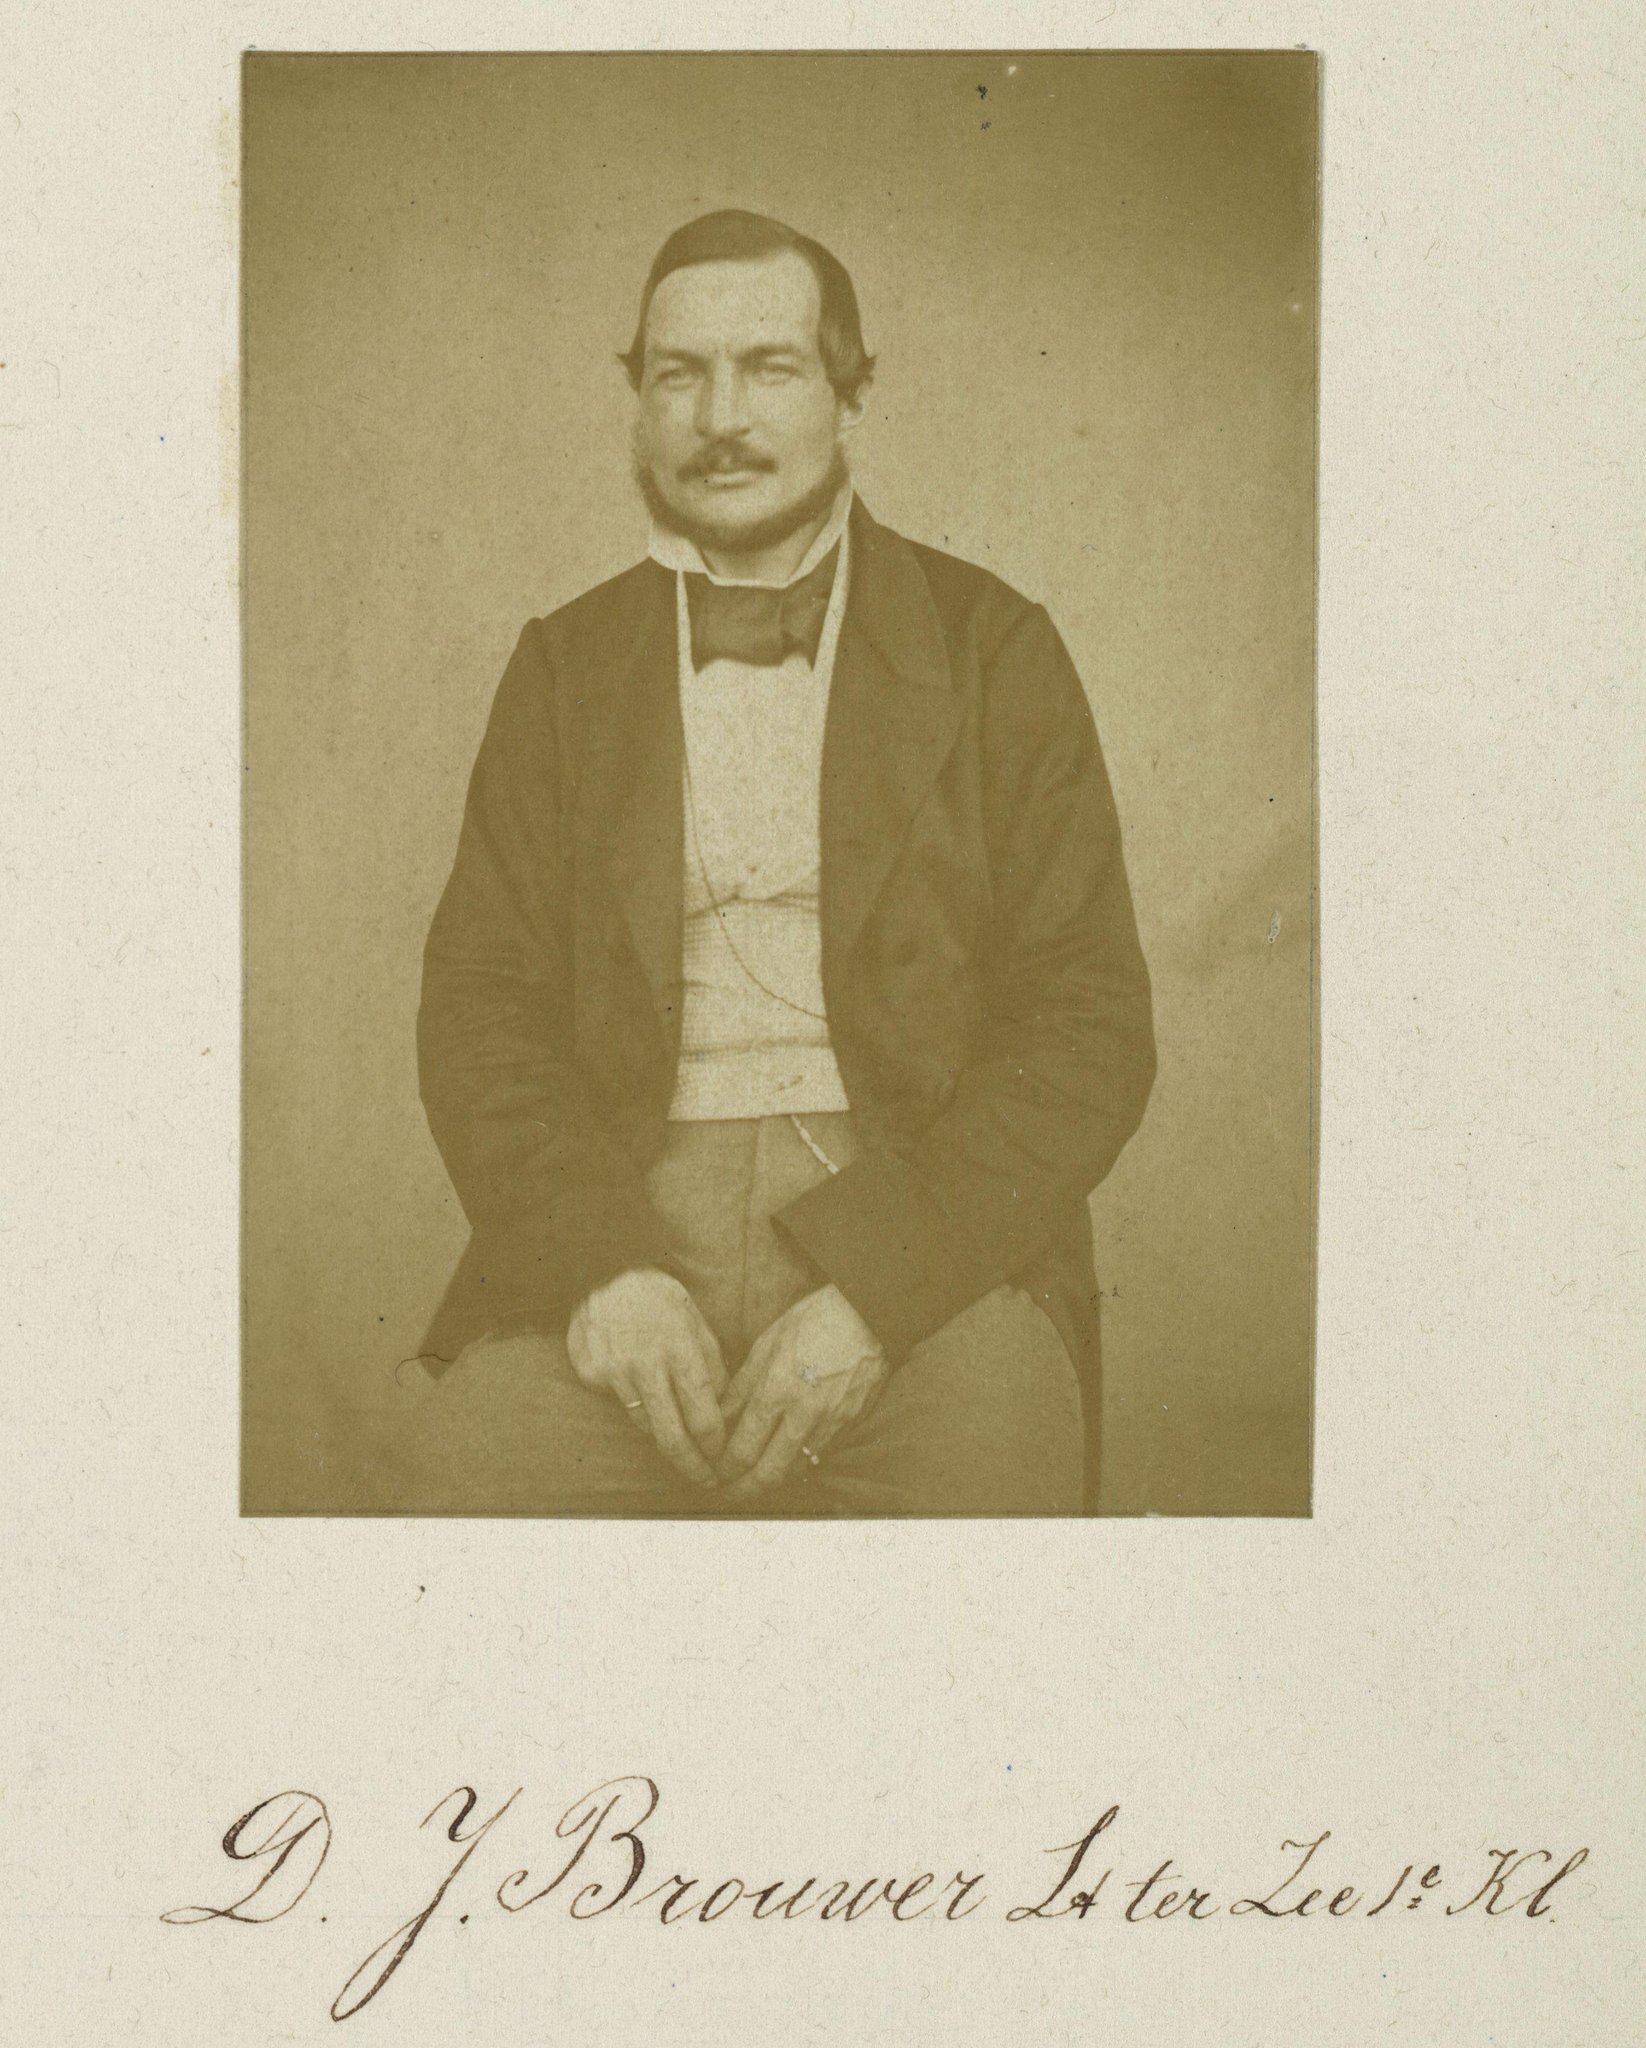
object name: photograph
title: D.J. Brouwer Lt ter Zee 1e Kl.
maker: pieter jan kaiser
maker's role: fotograaf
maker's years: 1838-1916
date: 1855-1880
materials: cardboard, paper, photographic support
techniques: albumen print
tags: historical persons, science and technology (+ portrait of scholar, scientist)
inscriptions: inscription: ‘Tijdelijk belast met astronomische waarnemingen in de zwwvaart, bij de ... waart’, annotation: ‘D.J. Brouwer Lt ter Zee 1e Kl.’